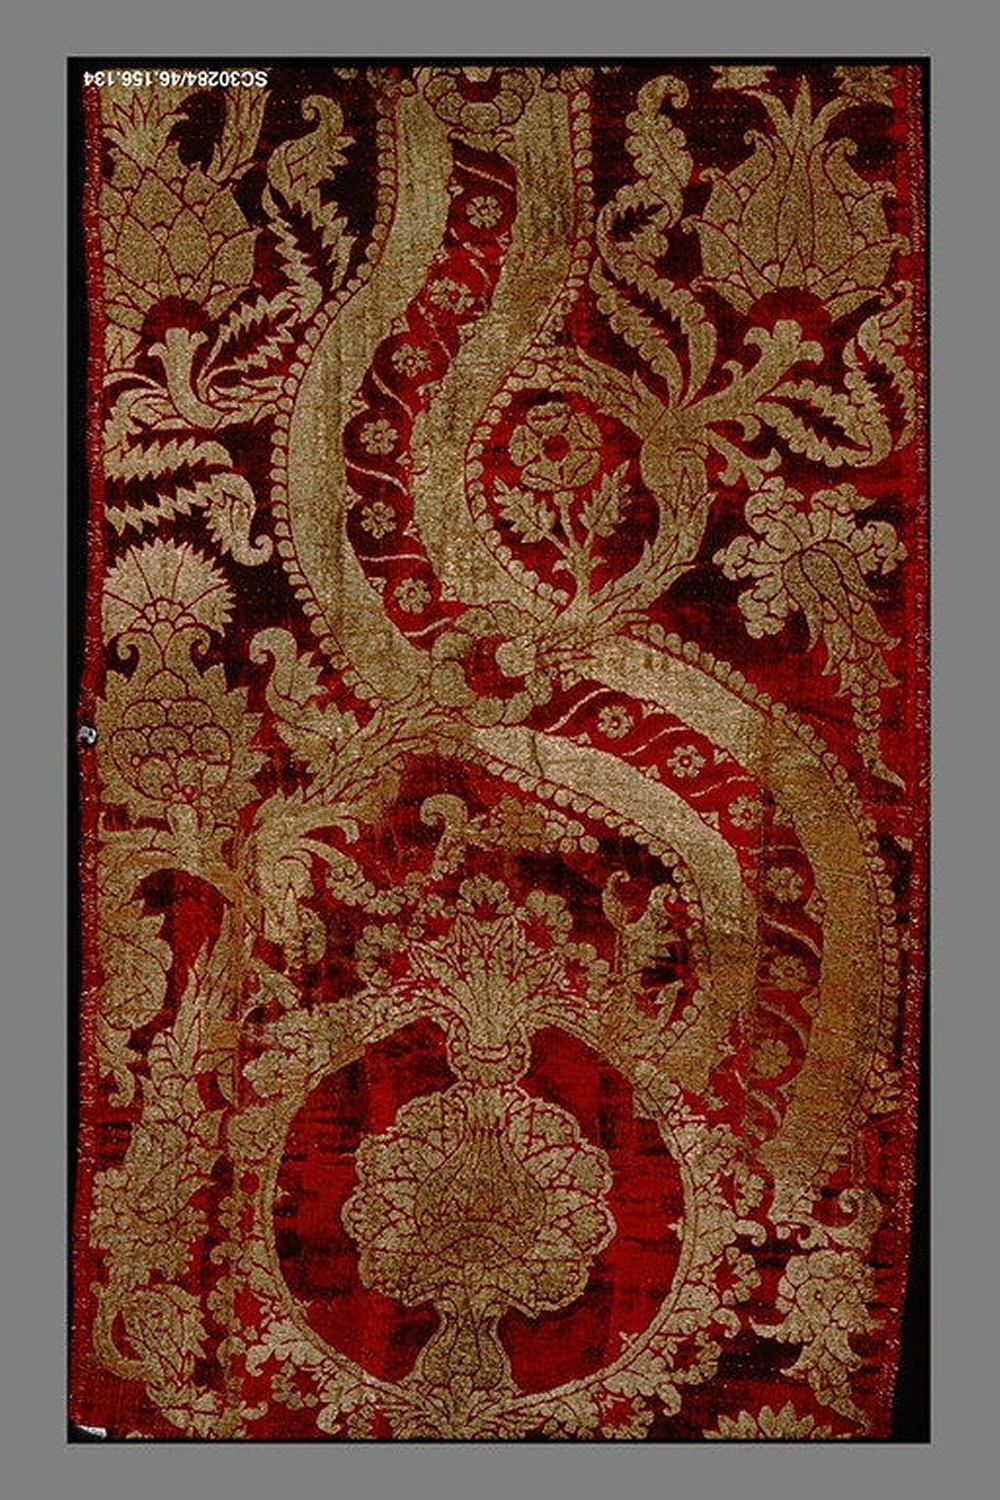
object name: panel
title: Panel of velvet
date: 1451-1500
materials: metal thread, silk, velvet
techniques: brocade, cutting, voiding